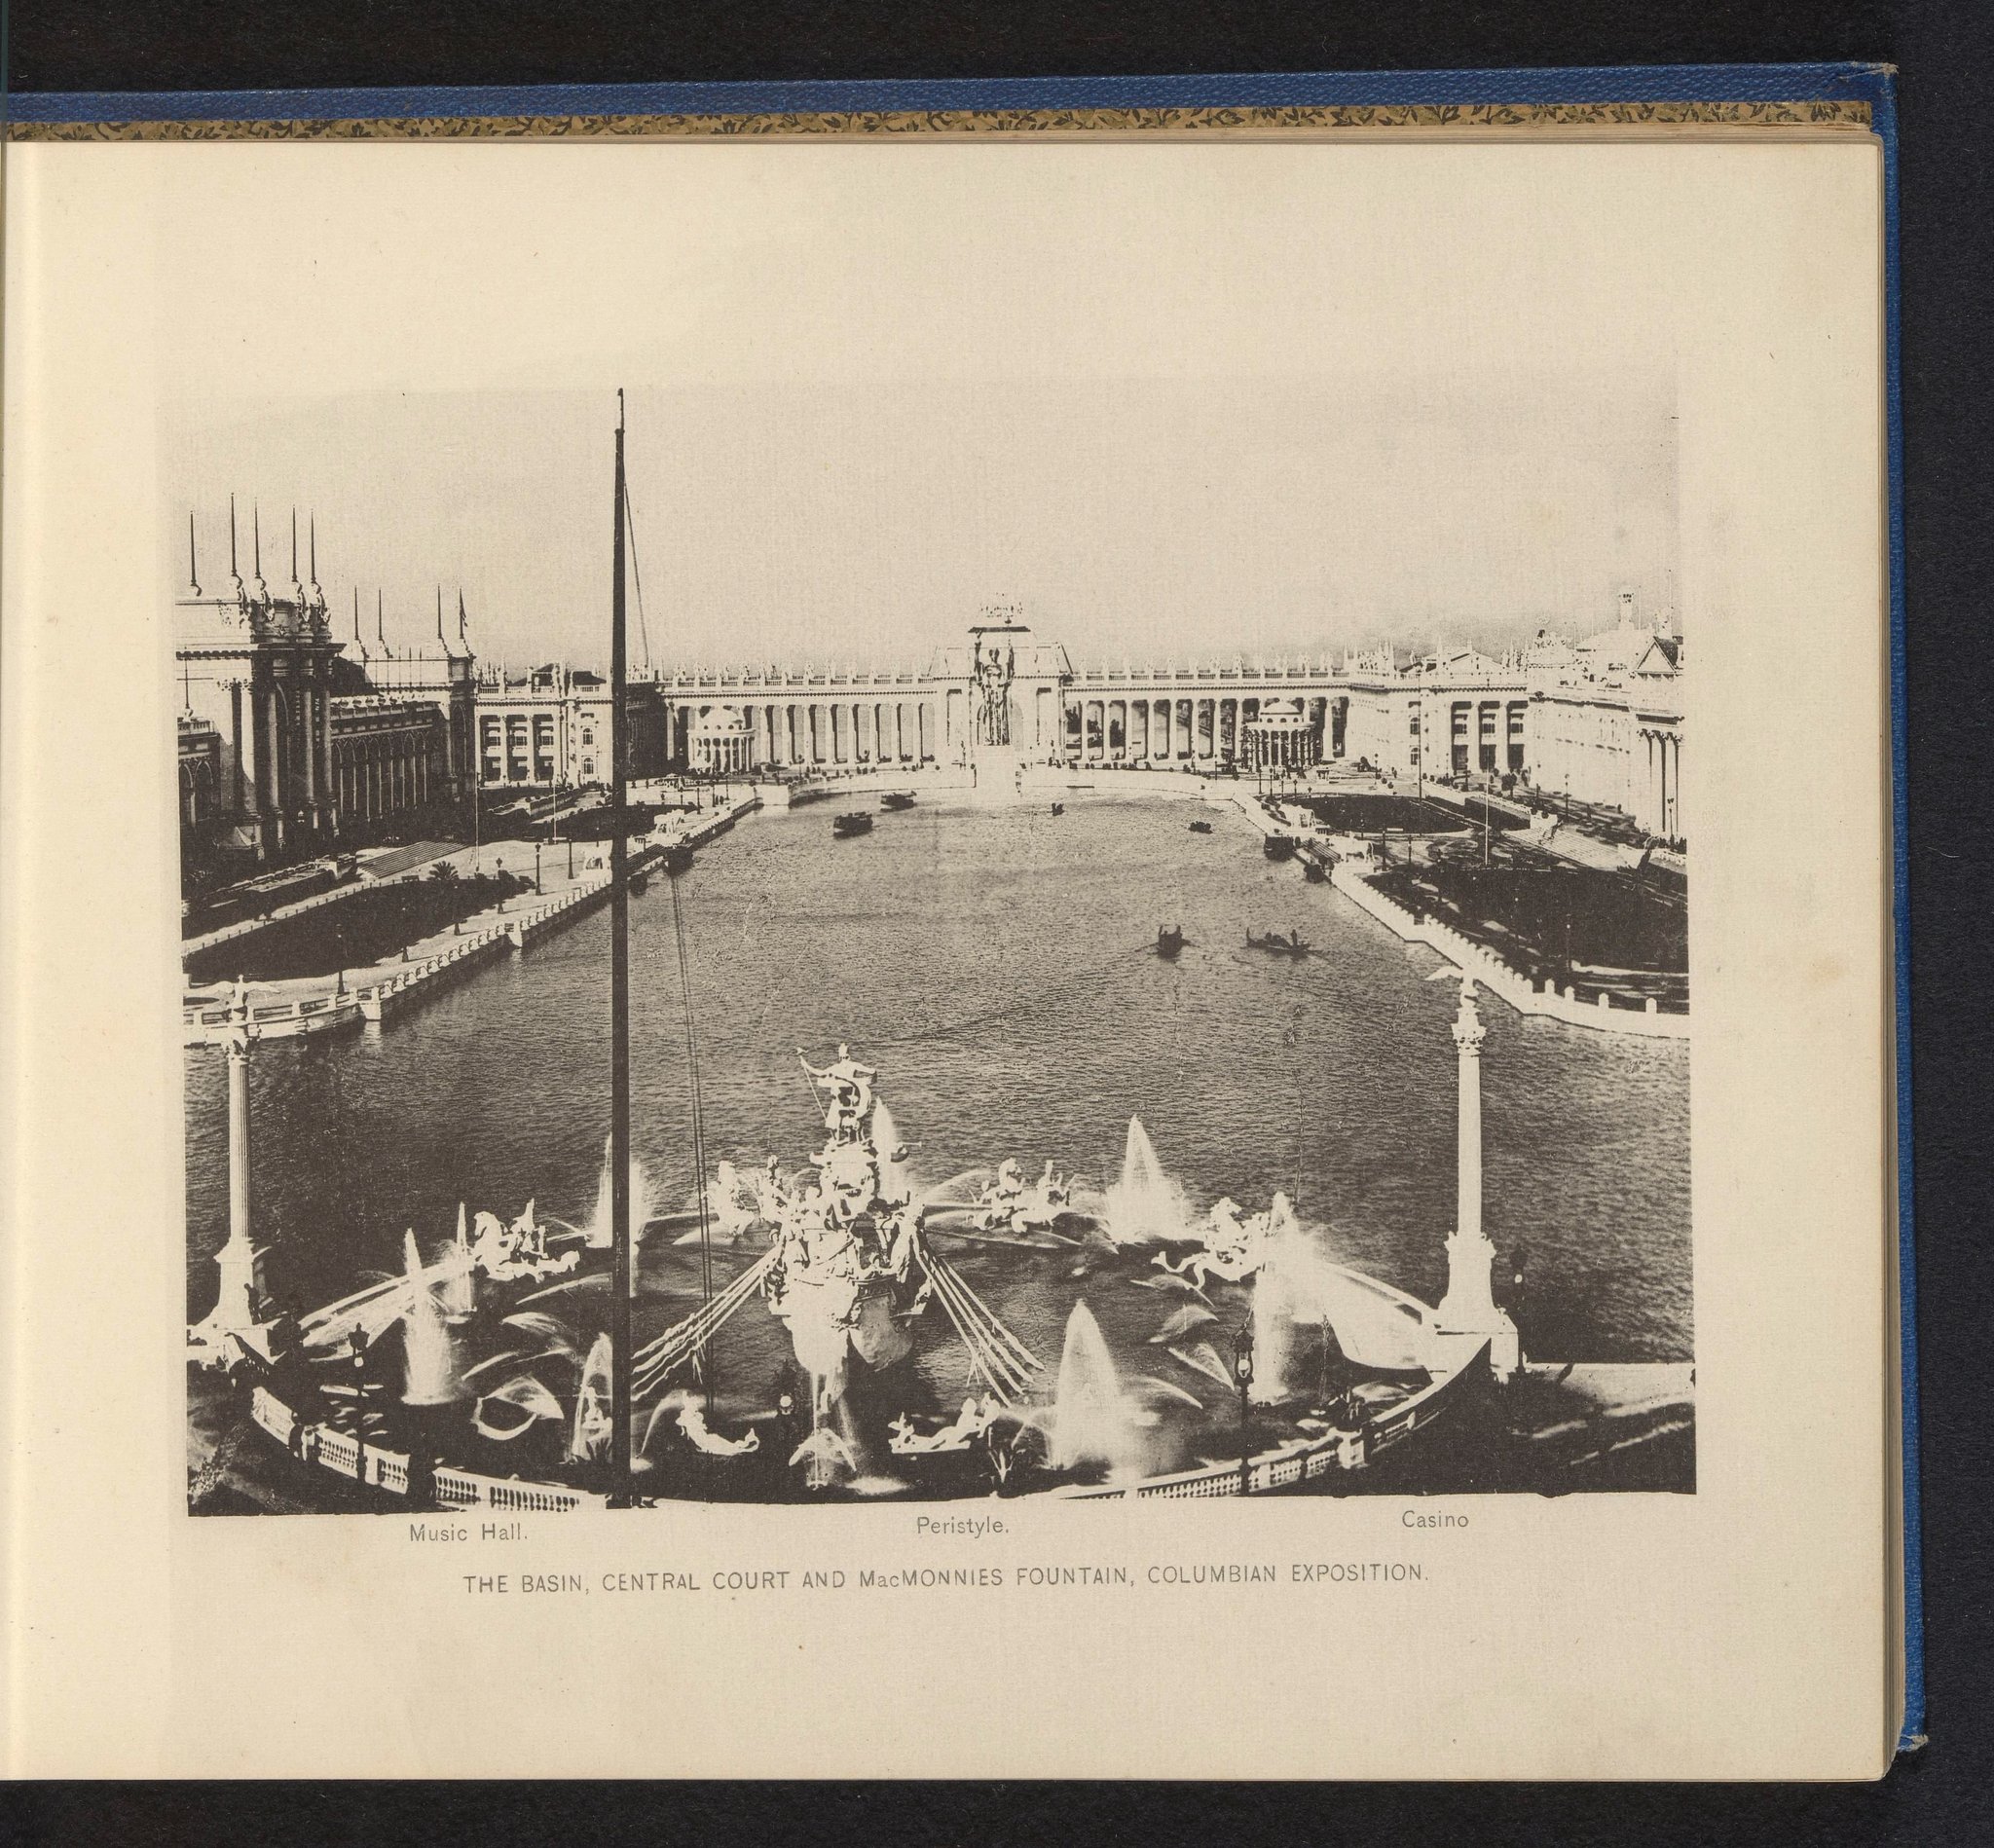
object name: photomechanical print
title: The Basin, Central Court and MacMonnies Fountain, Columbian Expostition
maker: Anonymous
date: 1893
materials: paper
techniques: photograph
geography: chicago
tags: world fair, world exhibition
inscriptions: inscription: ‘Music Hall. Peristyle. Casino’